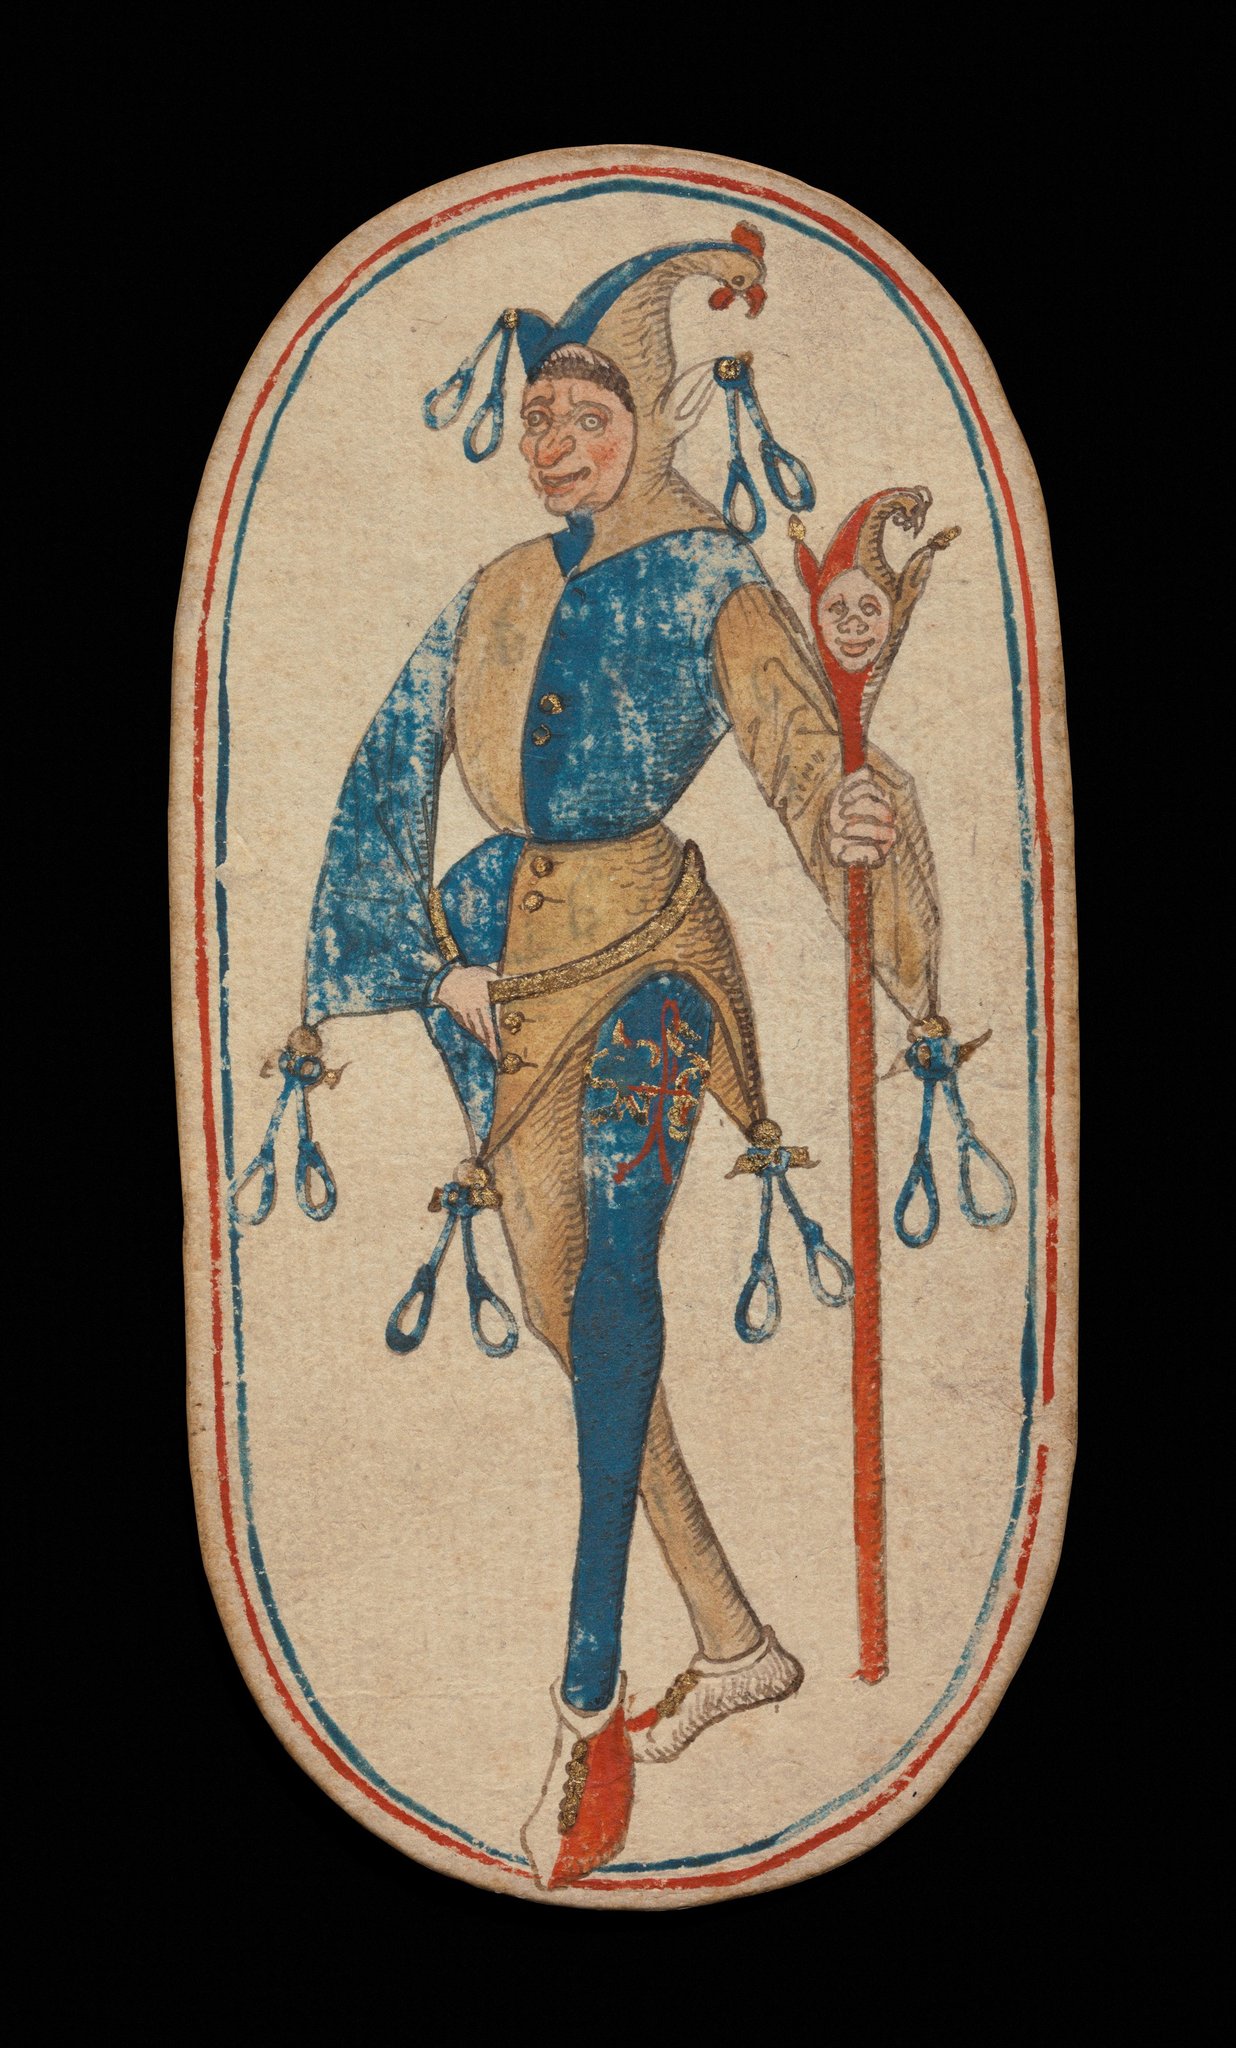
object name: playing card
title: Knave of Nooses, from The Cloisters Playing Cards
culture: south netherlandish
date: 1475-1480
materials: glaze, gold, ink, paint, paper, silver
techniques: pen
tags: men,playing cards,games